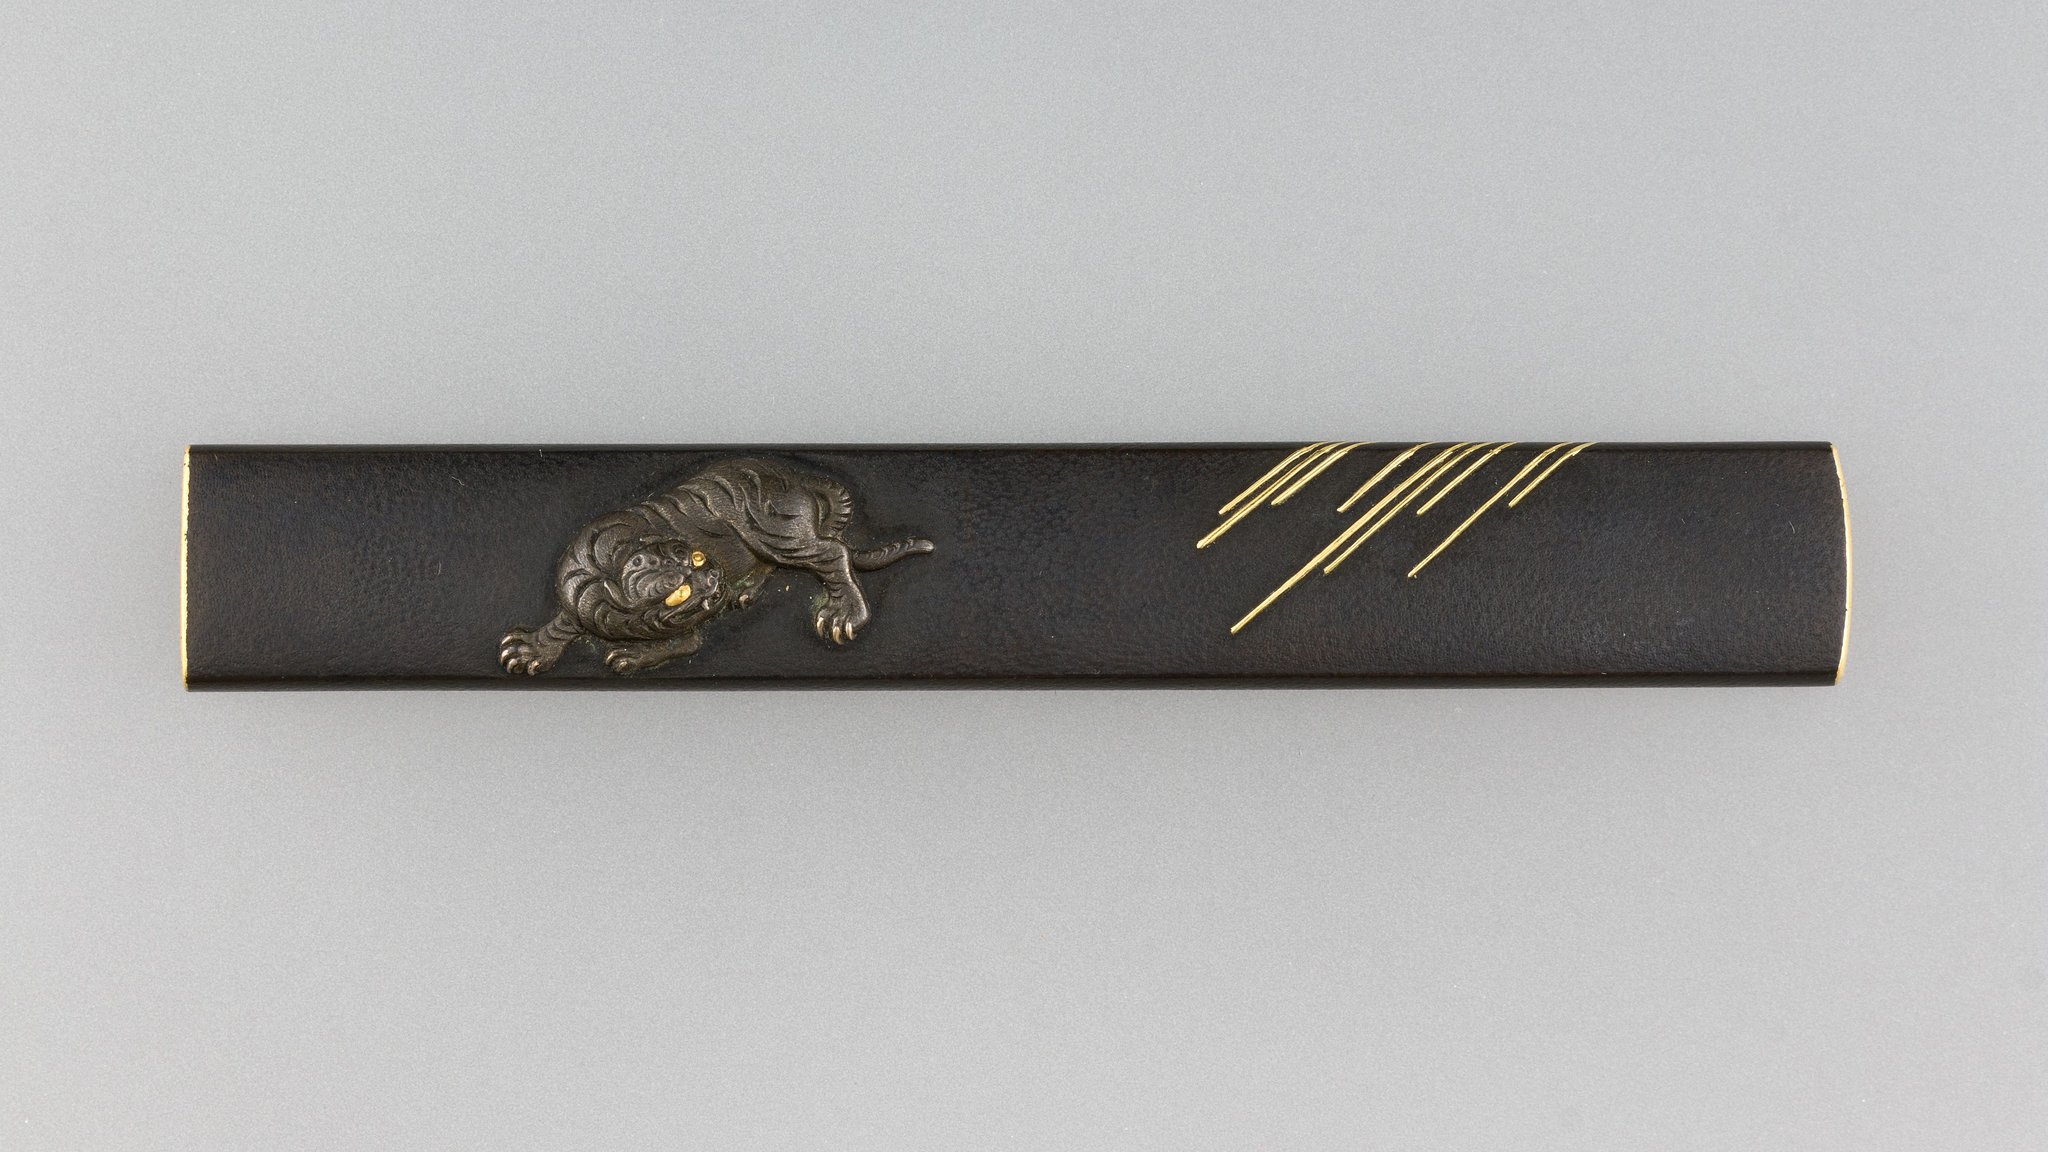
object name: knife handle kozuka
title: Knife Handle (Kozuka)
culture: japanese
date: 1770-1852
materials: gold alloy, silver alloy, gold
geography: japan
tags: tigers